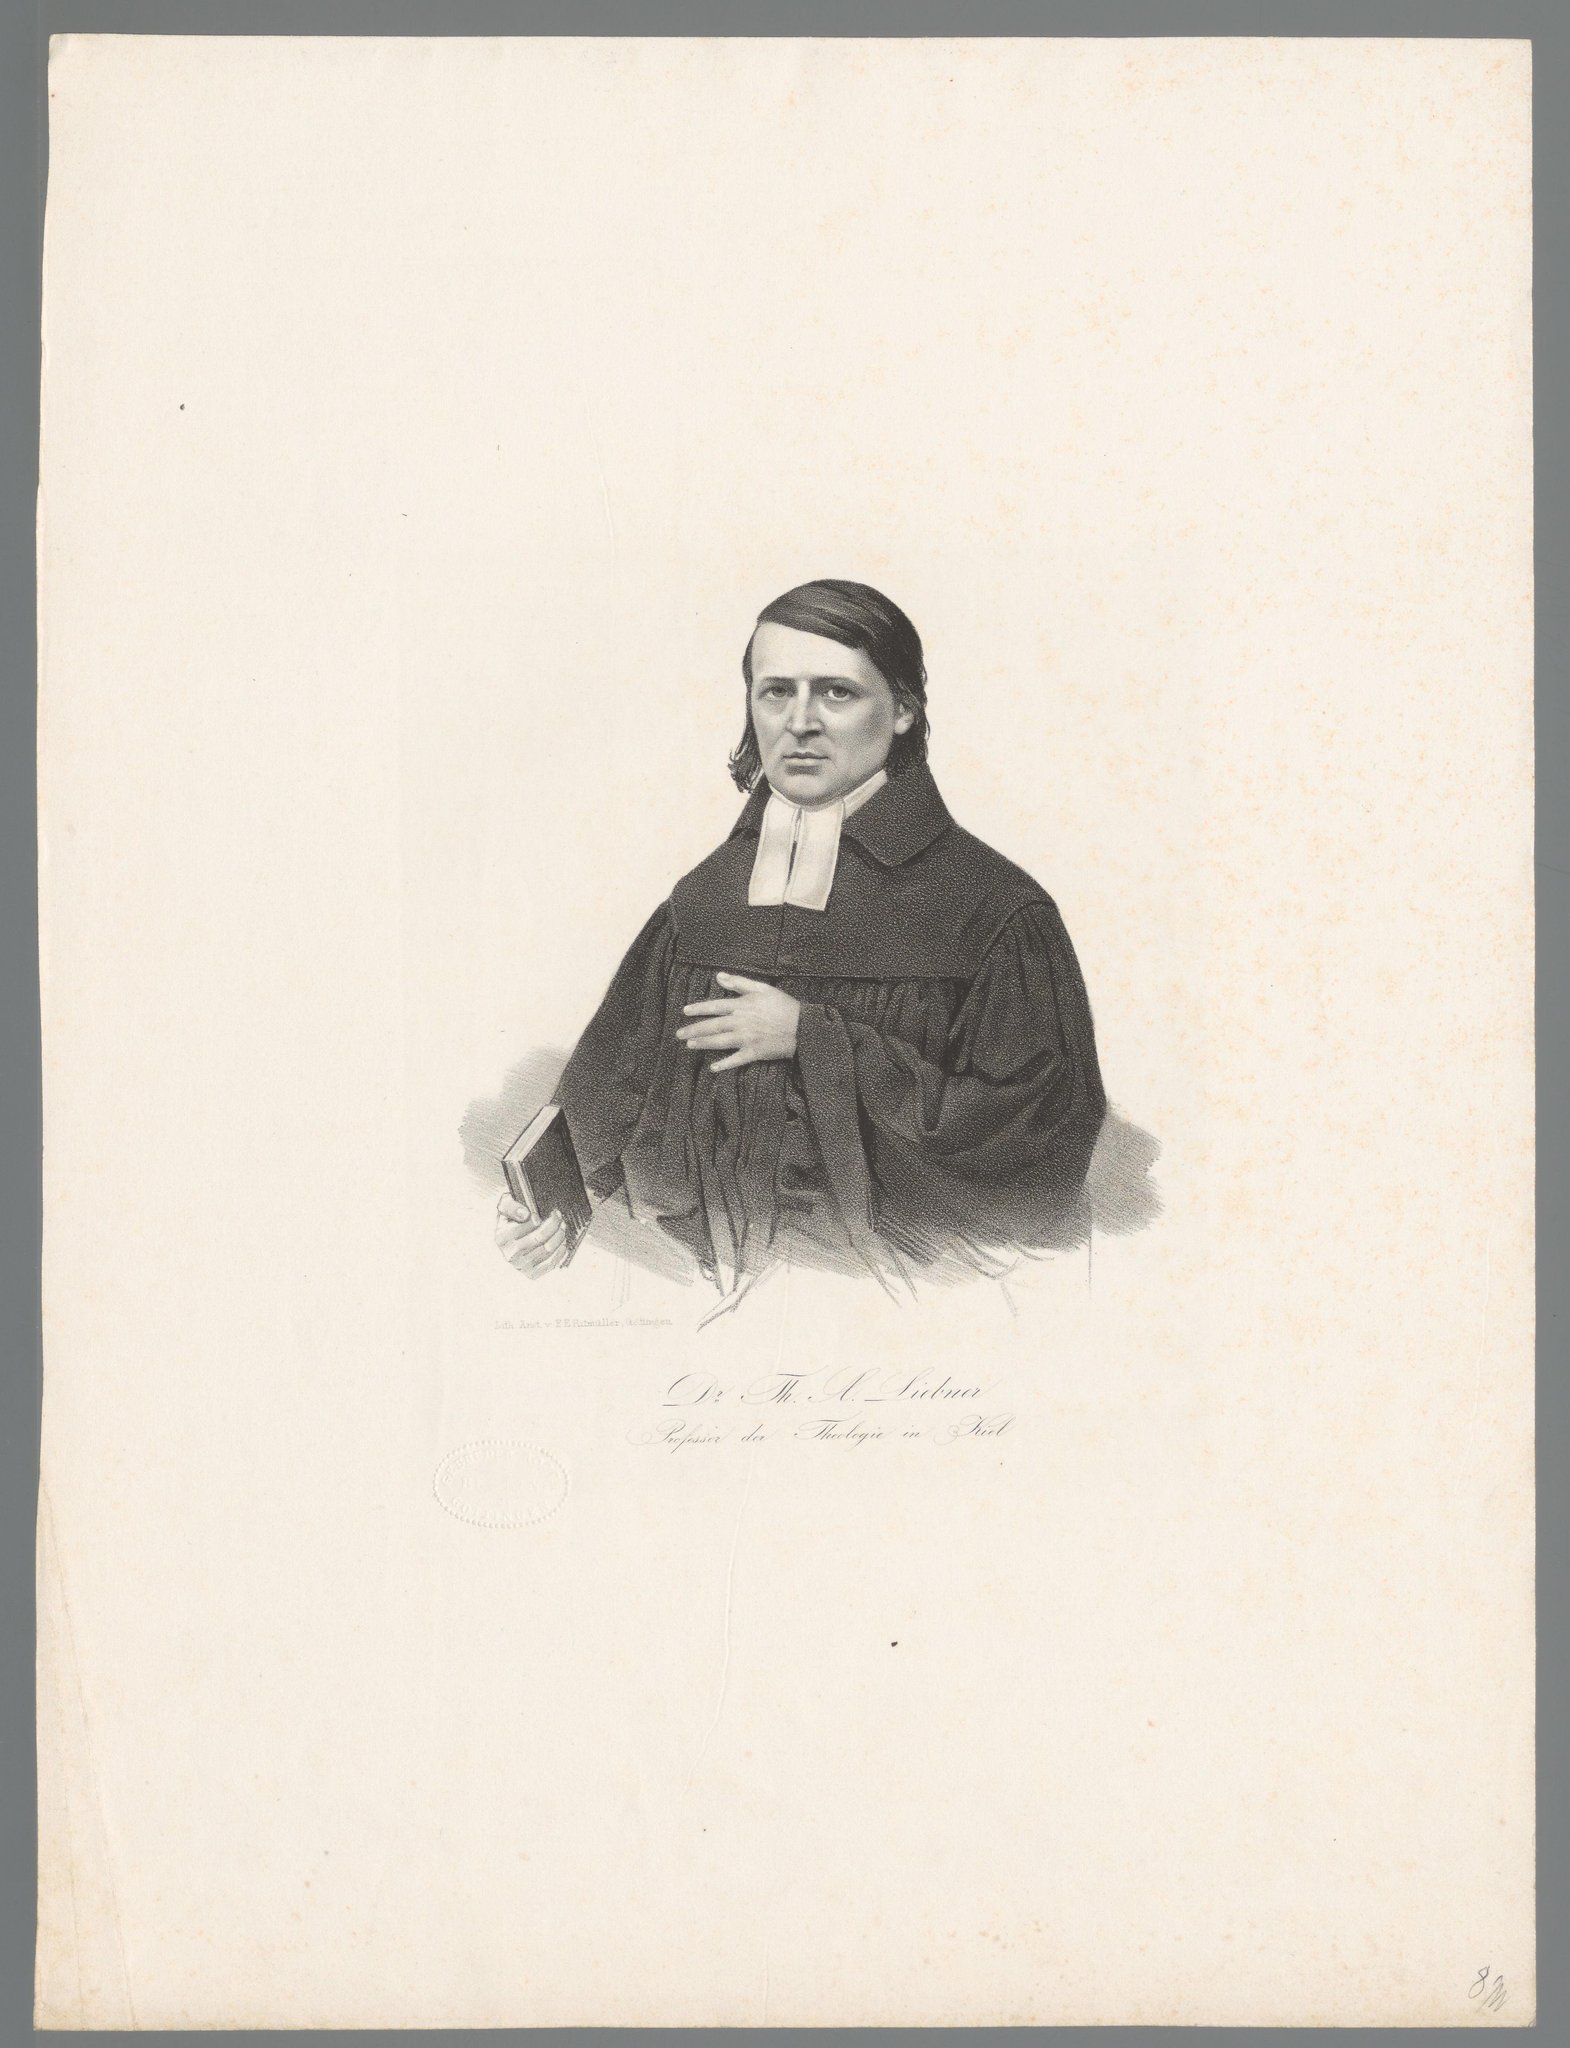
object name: print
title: Portret van Karl Theodor Albert Liebner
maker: friedrich eduard ritmüller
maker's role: printer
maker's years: 1805-1869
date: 1830-1863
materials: paper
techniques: lithograph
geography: gottingen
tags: theologian, historical persons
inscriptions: check stamp: Lugt 5514, collector's mark: Lugt 2228